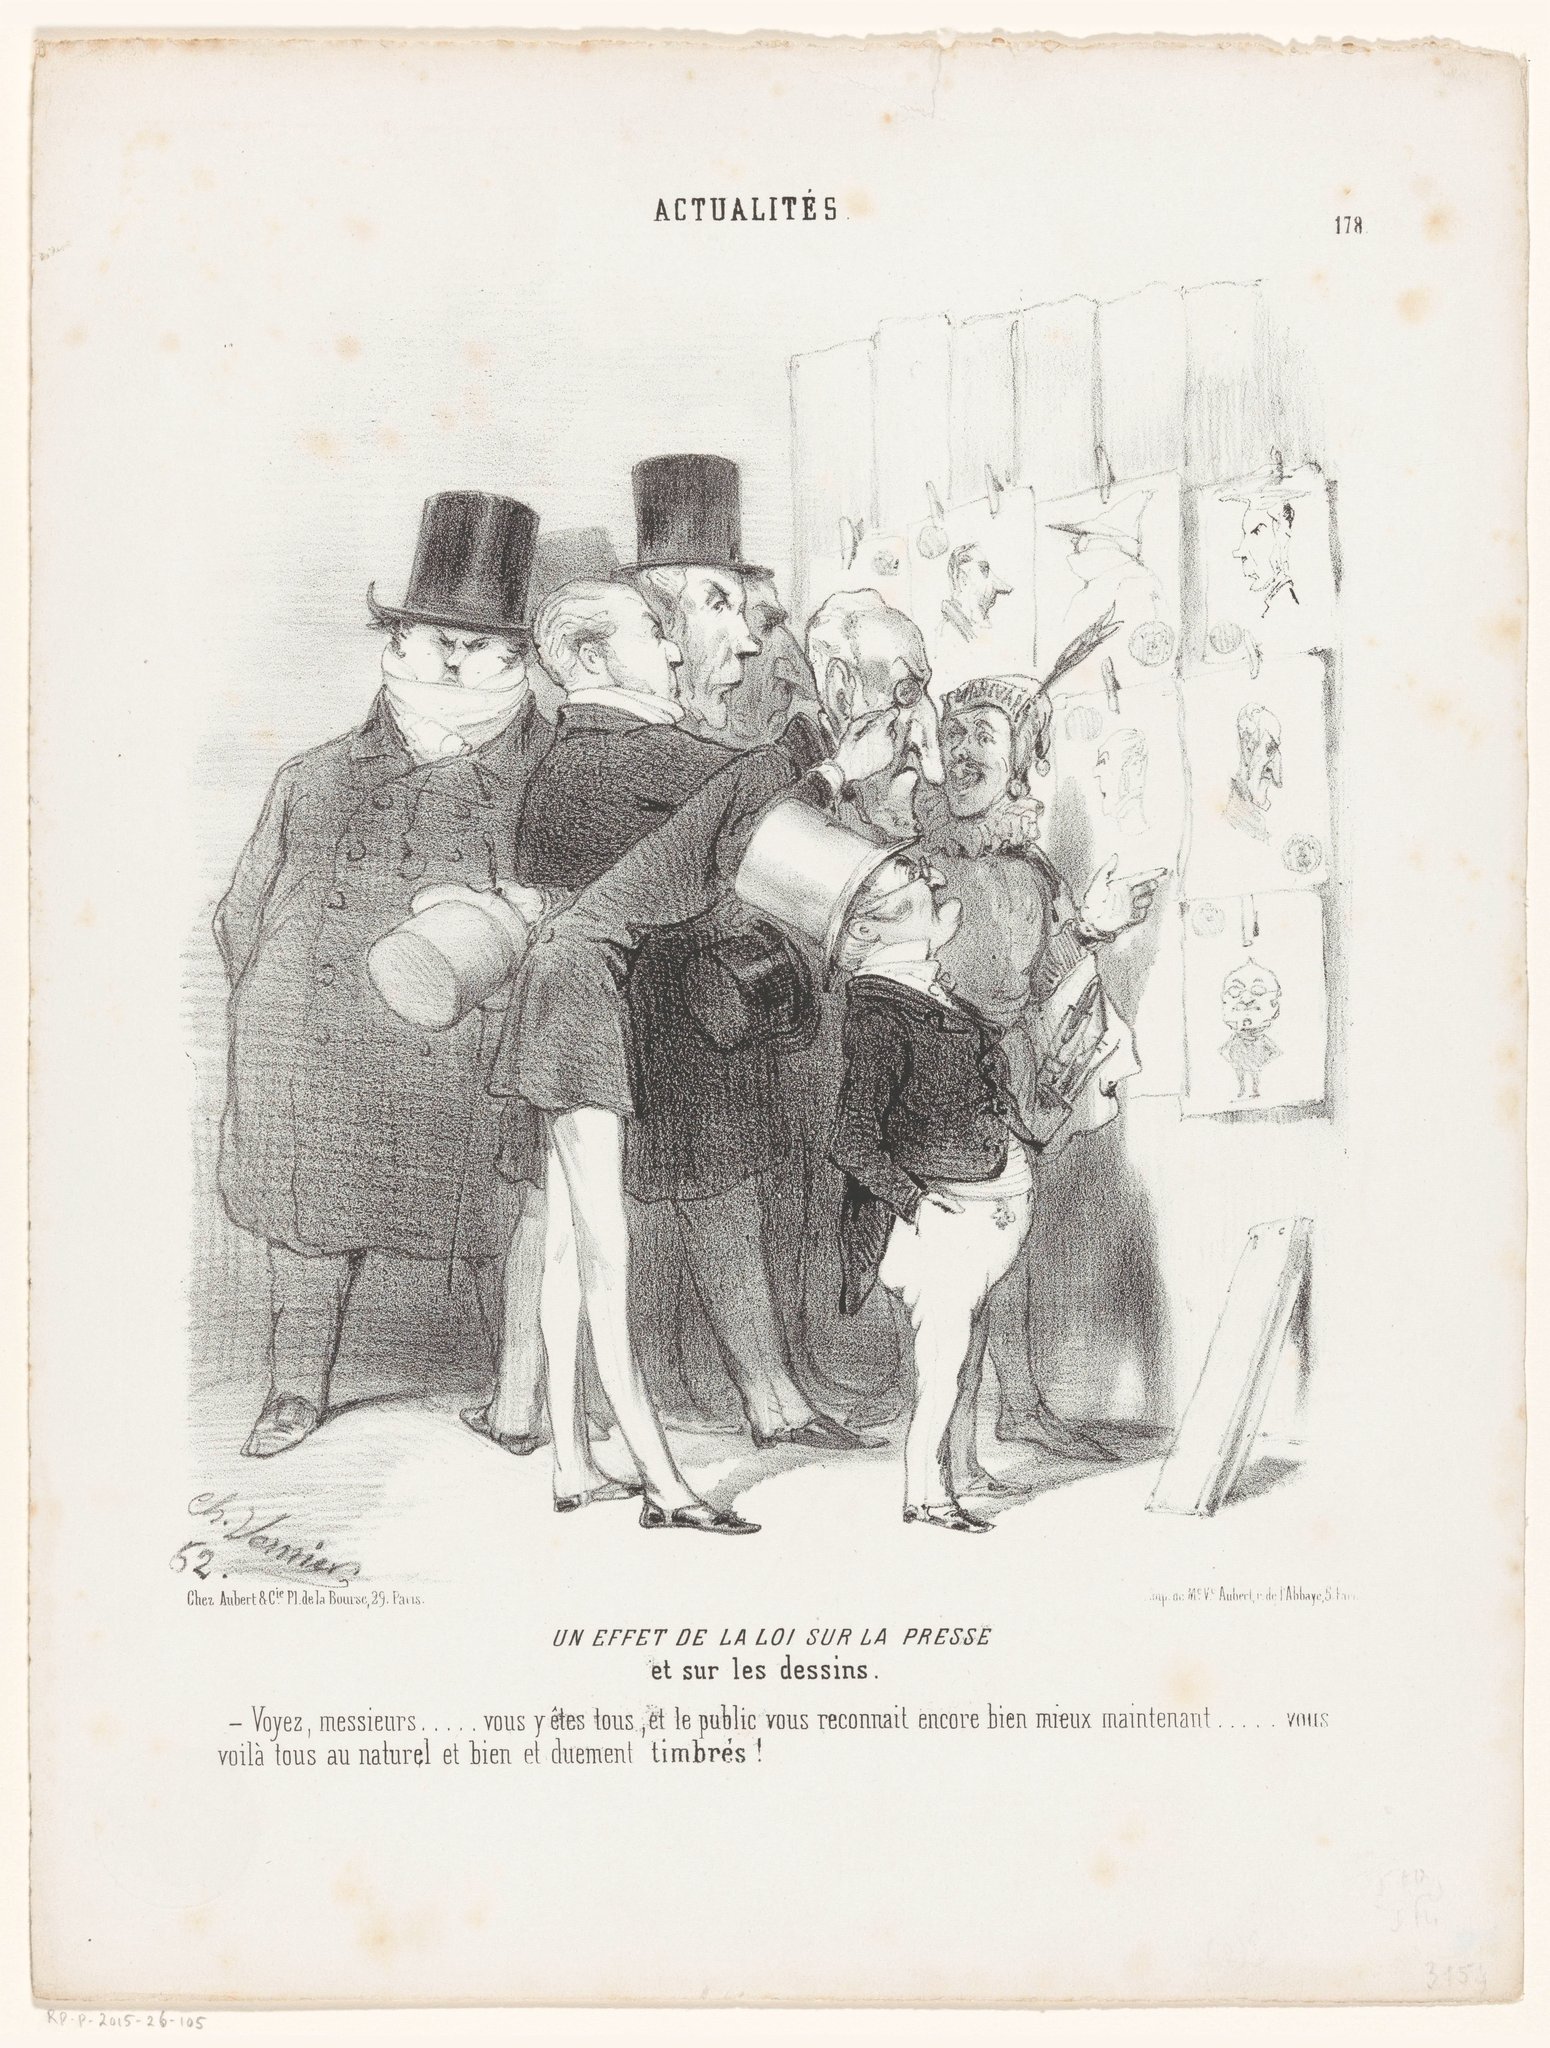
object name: print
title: Spotprent op de Franse perswet van 1852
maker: charles vernier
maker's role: draughtsman, print maker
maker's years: 1831-1887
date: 1852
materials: paper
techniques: lithograph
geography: paris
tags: censorship, historical persons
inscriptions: stamp: ‘Timbre cen. 5. Oudine et Vauthier Seine’, collector's mark: Lugt 2228, collector's mark: Lugt 4780, collector's mark: Lugt 4779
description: Een nar, voorstellende het tijdschrift Charivari, prijst enkele portretten aan bij een groep deftige heren. In de prenten of tekeningen herkennen zij hun eigen beeldtenis. Rechtsboven genummerd: 178.